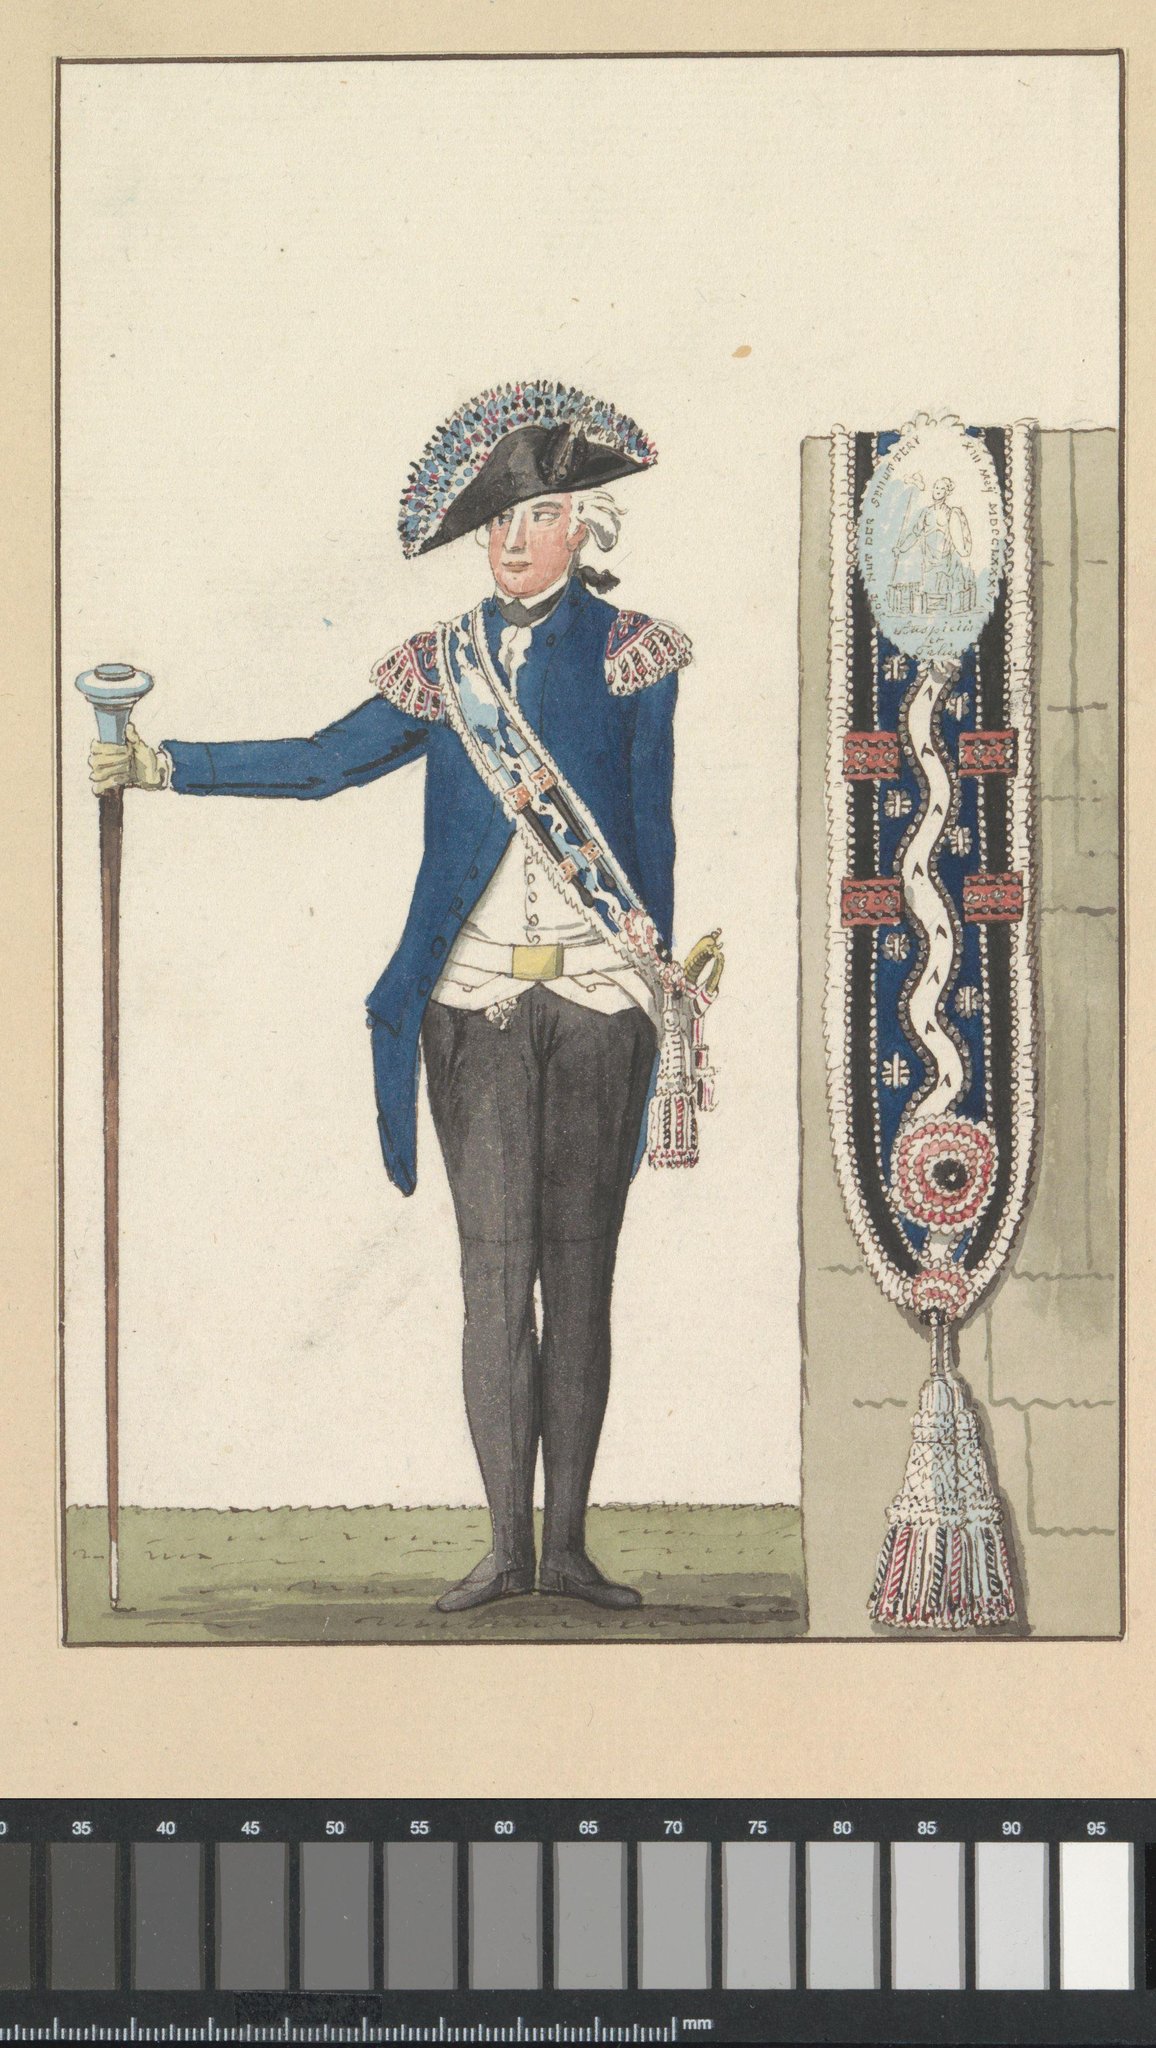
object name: costume print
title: Drum-major of the Society for the Benefit of the Militia in Amsterdam, 1787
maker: Anonymous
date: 1787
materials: paper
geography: amsterdam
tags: (military) uniforms (+ citizen soldiery, civil guard, citizen militia), amsterdam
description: Tamboer majoor, staande met de baton in rechterhand rustend op de grond, gezien van voren. Rechts een detail van de gedecoreerde tamboersbandelier. Onderdeel van het album met veertien ingeplakte gekleurde tekeningen van de uniformen van schutters van het patriotse Genootschap tot Nut der Schutterij te Amsterdam in het jaar 1787.